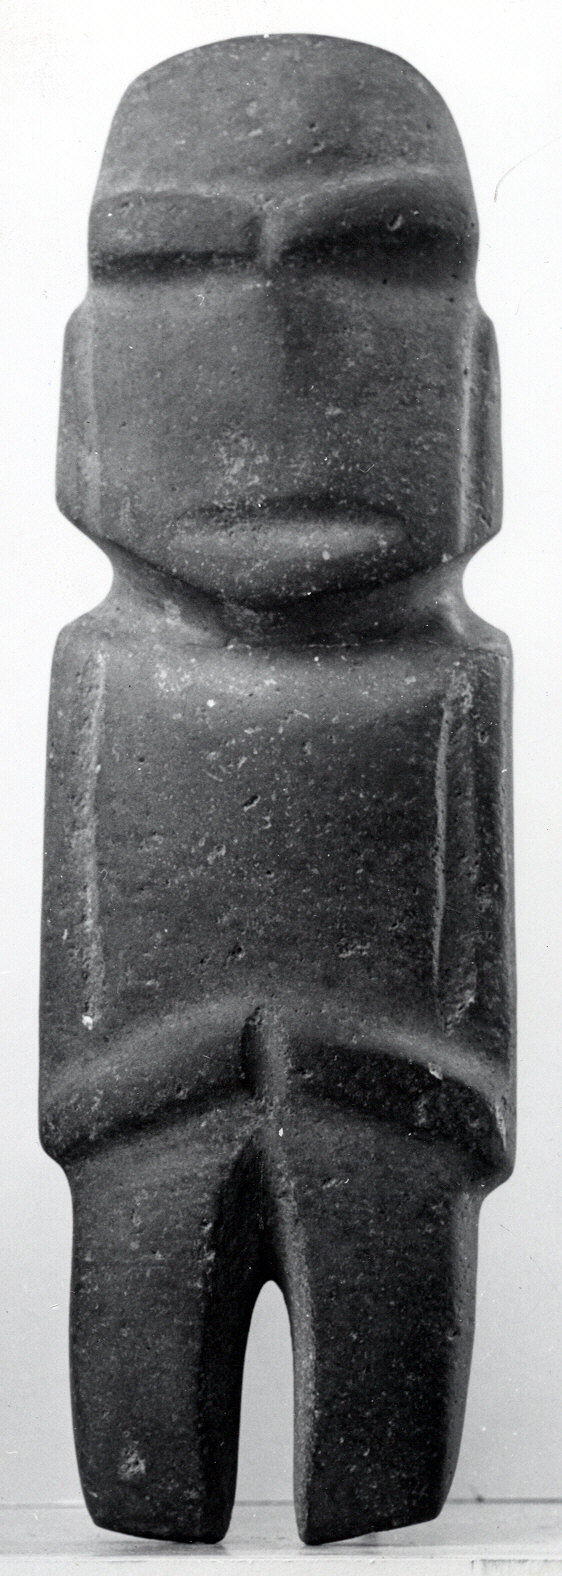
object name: figure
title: Standing Figure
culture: mezcala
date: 1-800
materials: stone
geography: mexico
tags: human figures